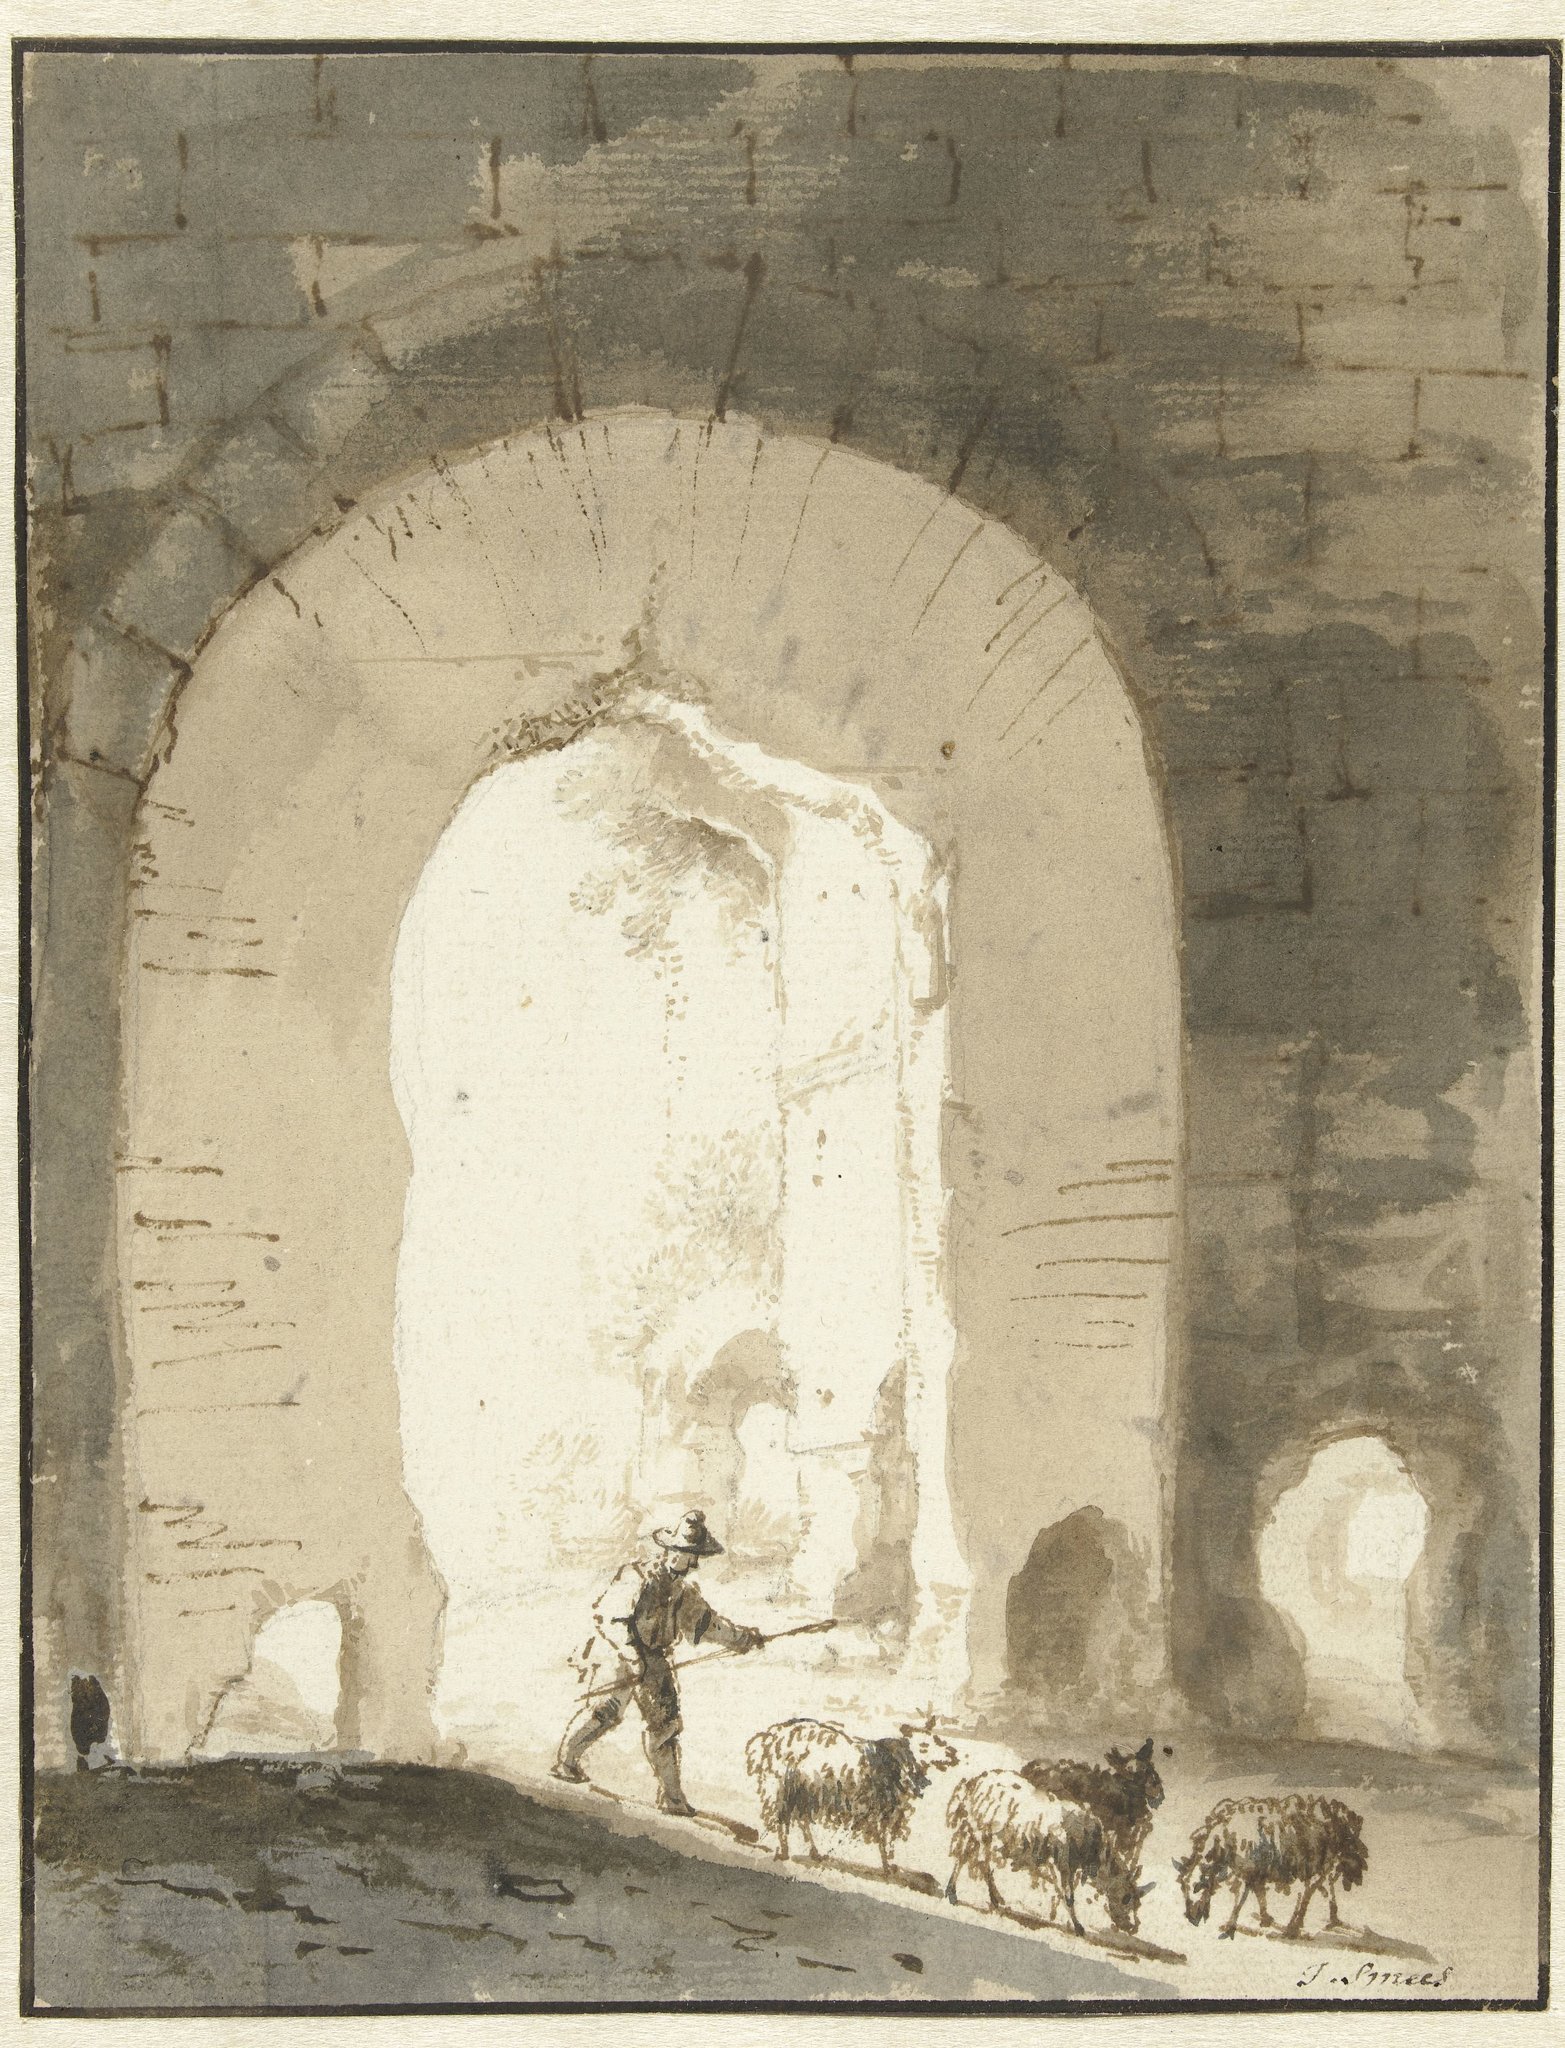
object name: drawing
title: Schaapherder bij ruïne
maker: jan smees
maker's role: draughtsman, print maker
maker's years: 1670-1729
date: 1705-1729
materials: ink, paper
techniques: brush, pen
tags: herding, herdsman, herdswoman, shepherd, shepherdess, cowherd, etc., ruin of a building ~ architecture, sheep